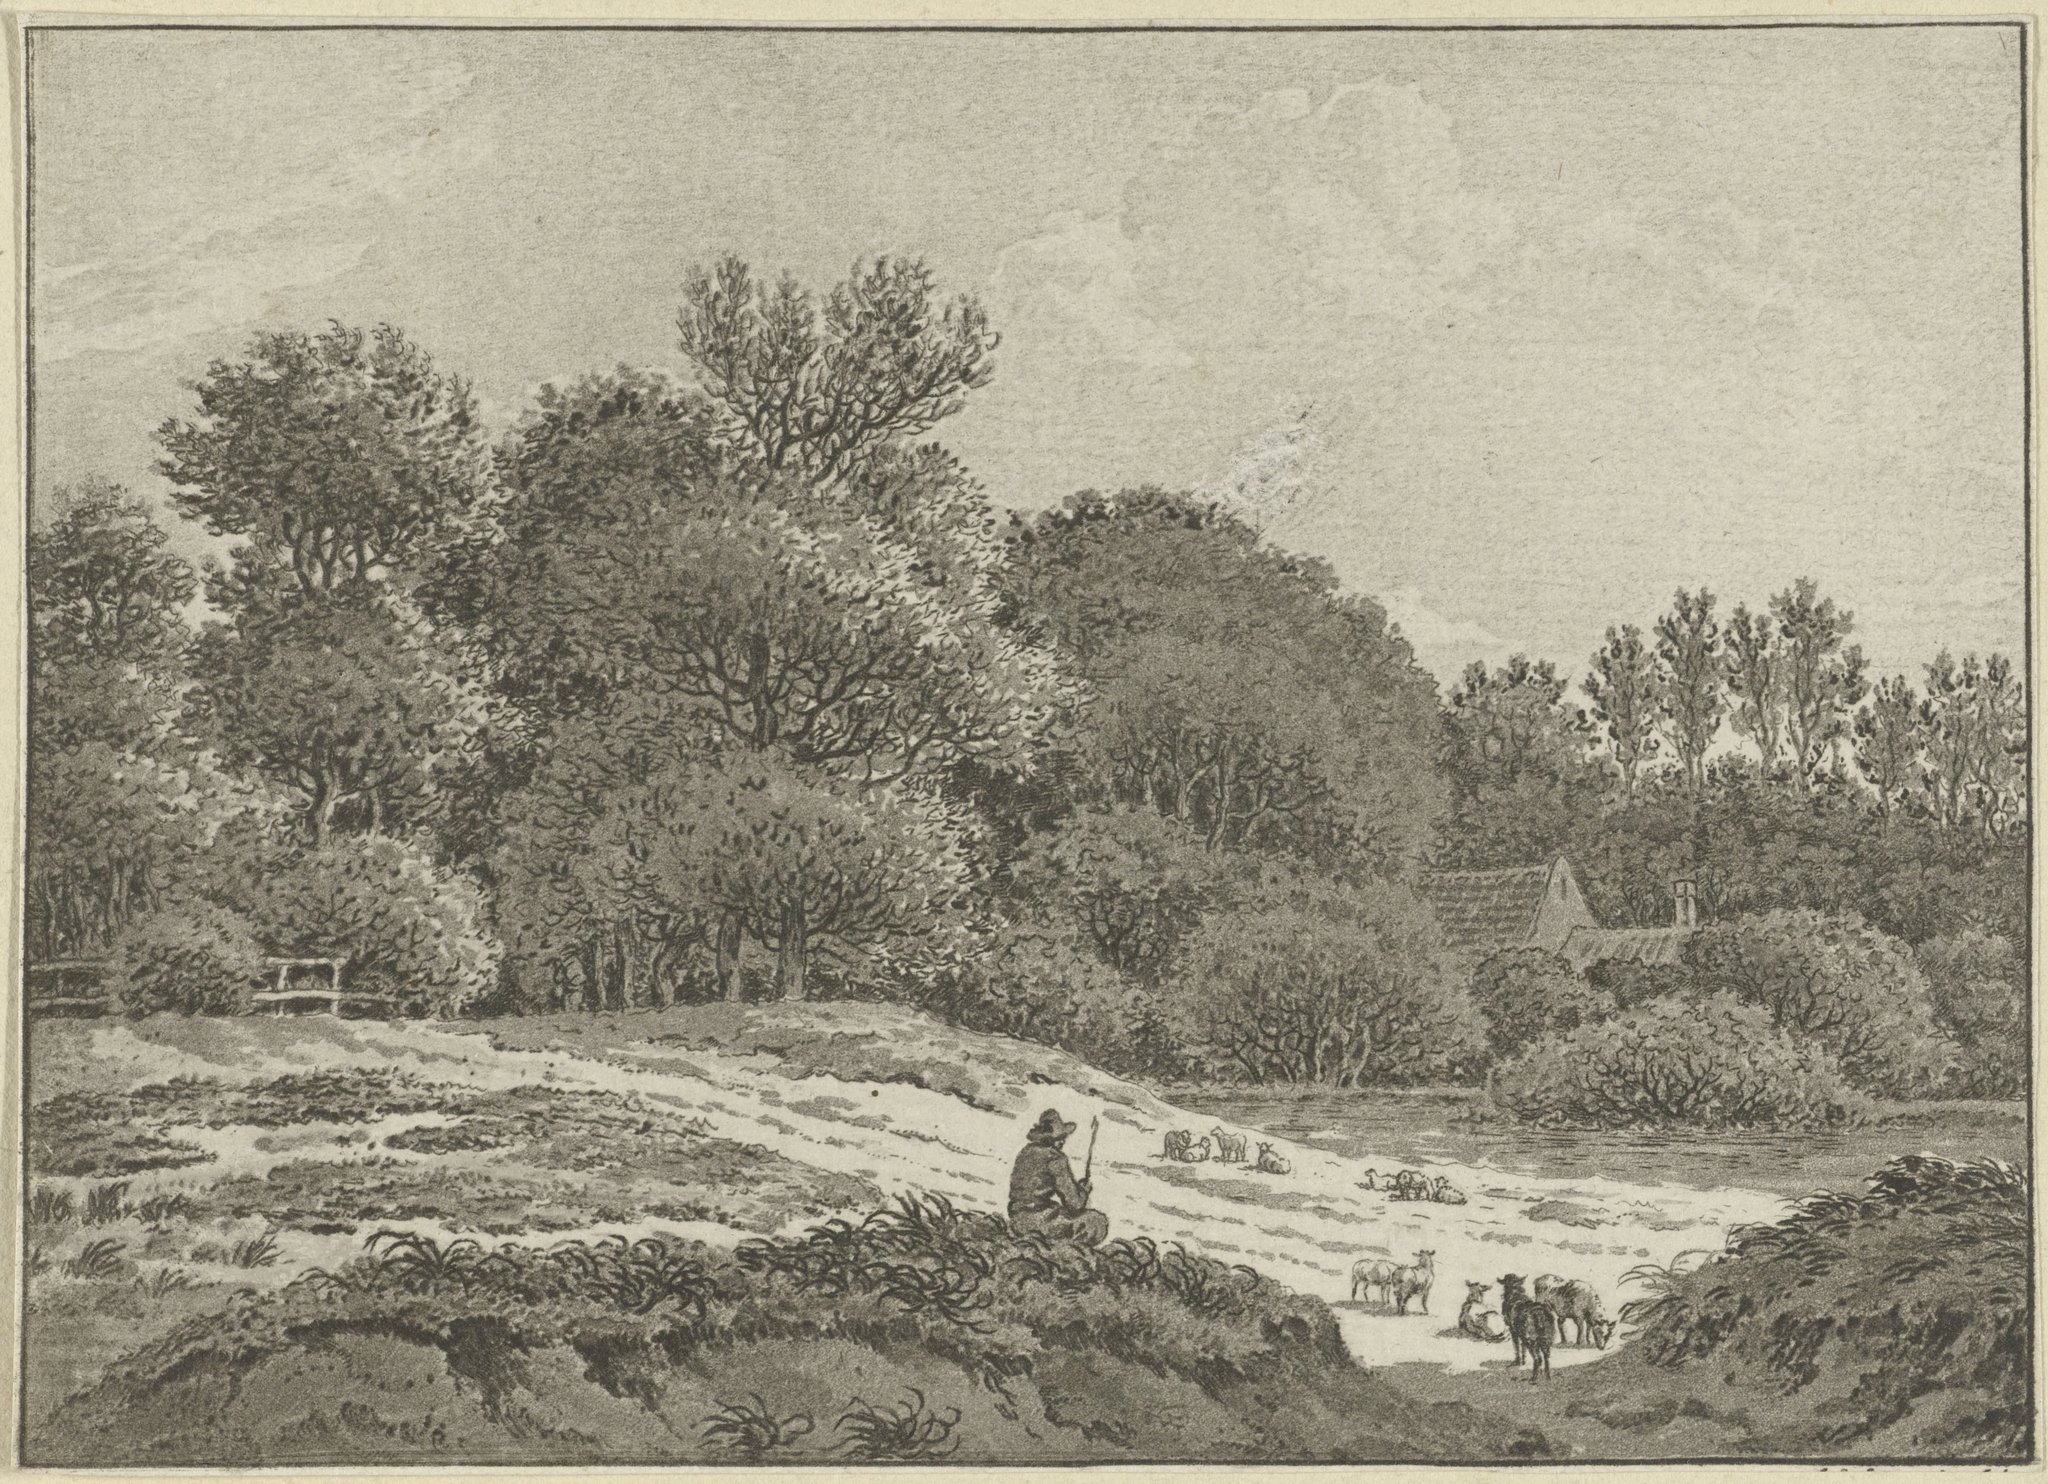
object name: print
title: Landschap bij Overveen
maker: jan evert grave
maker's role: draughtsman, print maker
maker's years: 1759-1805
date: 1769-1805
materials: paper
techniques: aquatint, etching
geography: amsterdam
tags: herding, herdsman, herdswoman, shepherd, shepherdess, cowherd, etc., forest, wood (+ landscape with figures, staffage)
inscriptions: collector's mark: Lugt 2233, number: ‘38’, collector's mark: Lugt 2228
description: Een bebost landschap bij Overveen, met een herder op de voorgrond. Hij zit op een heuveltje naast zijn kudde. Op de achtergrond een huis.